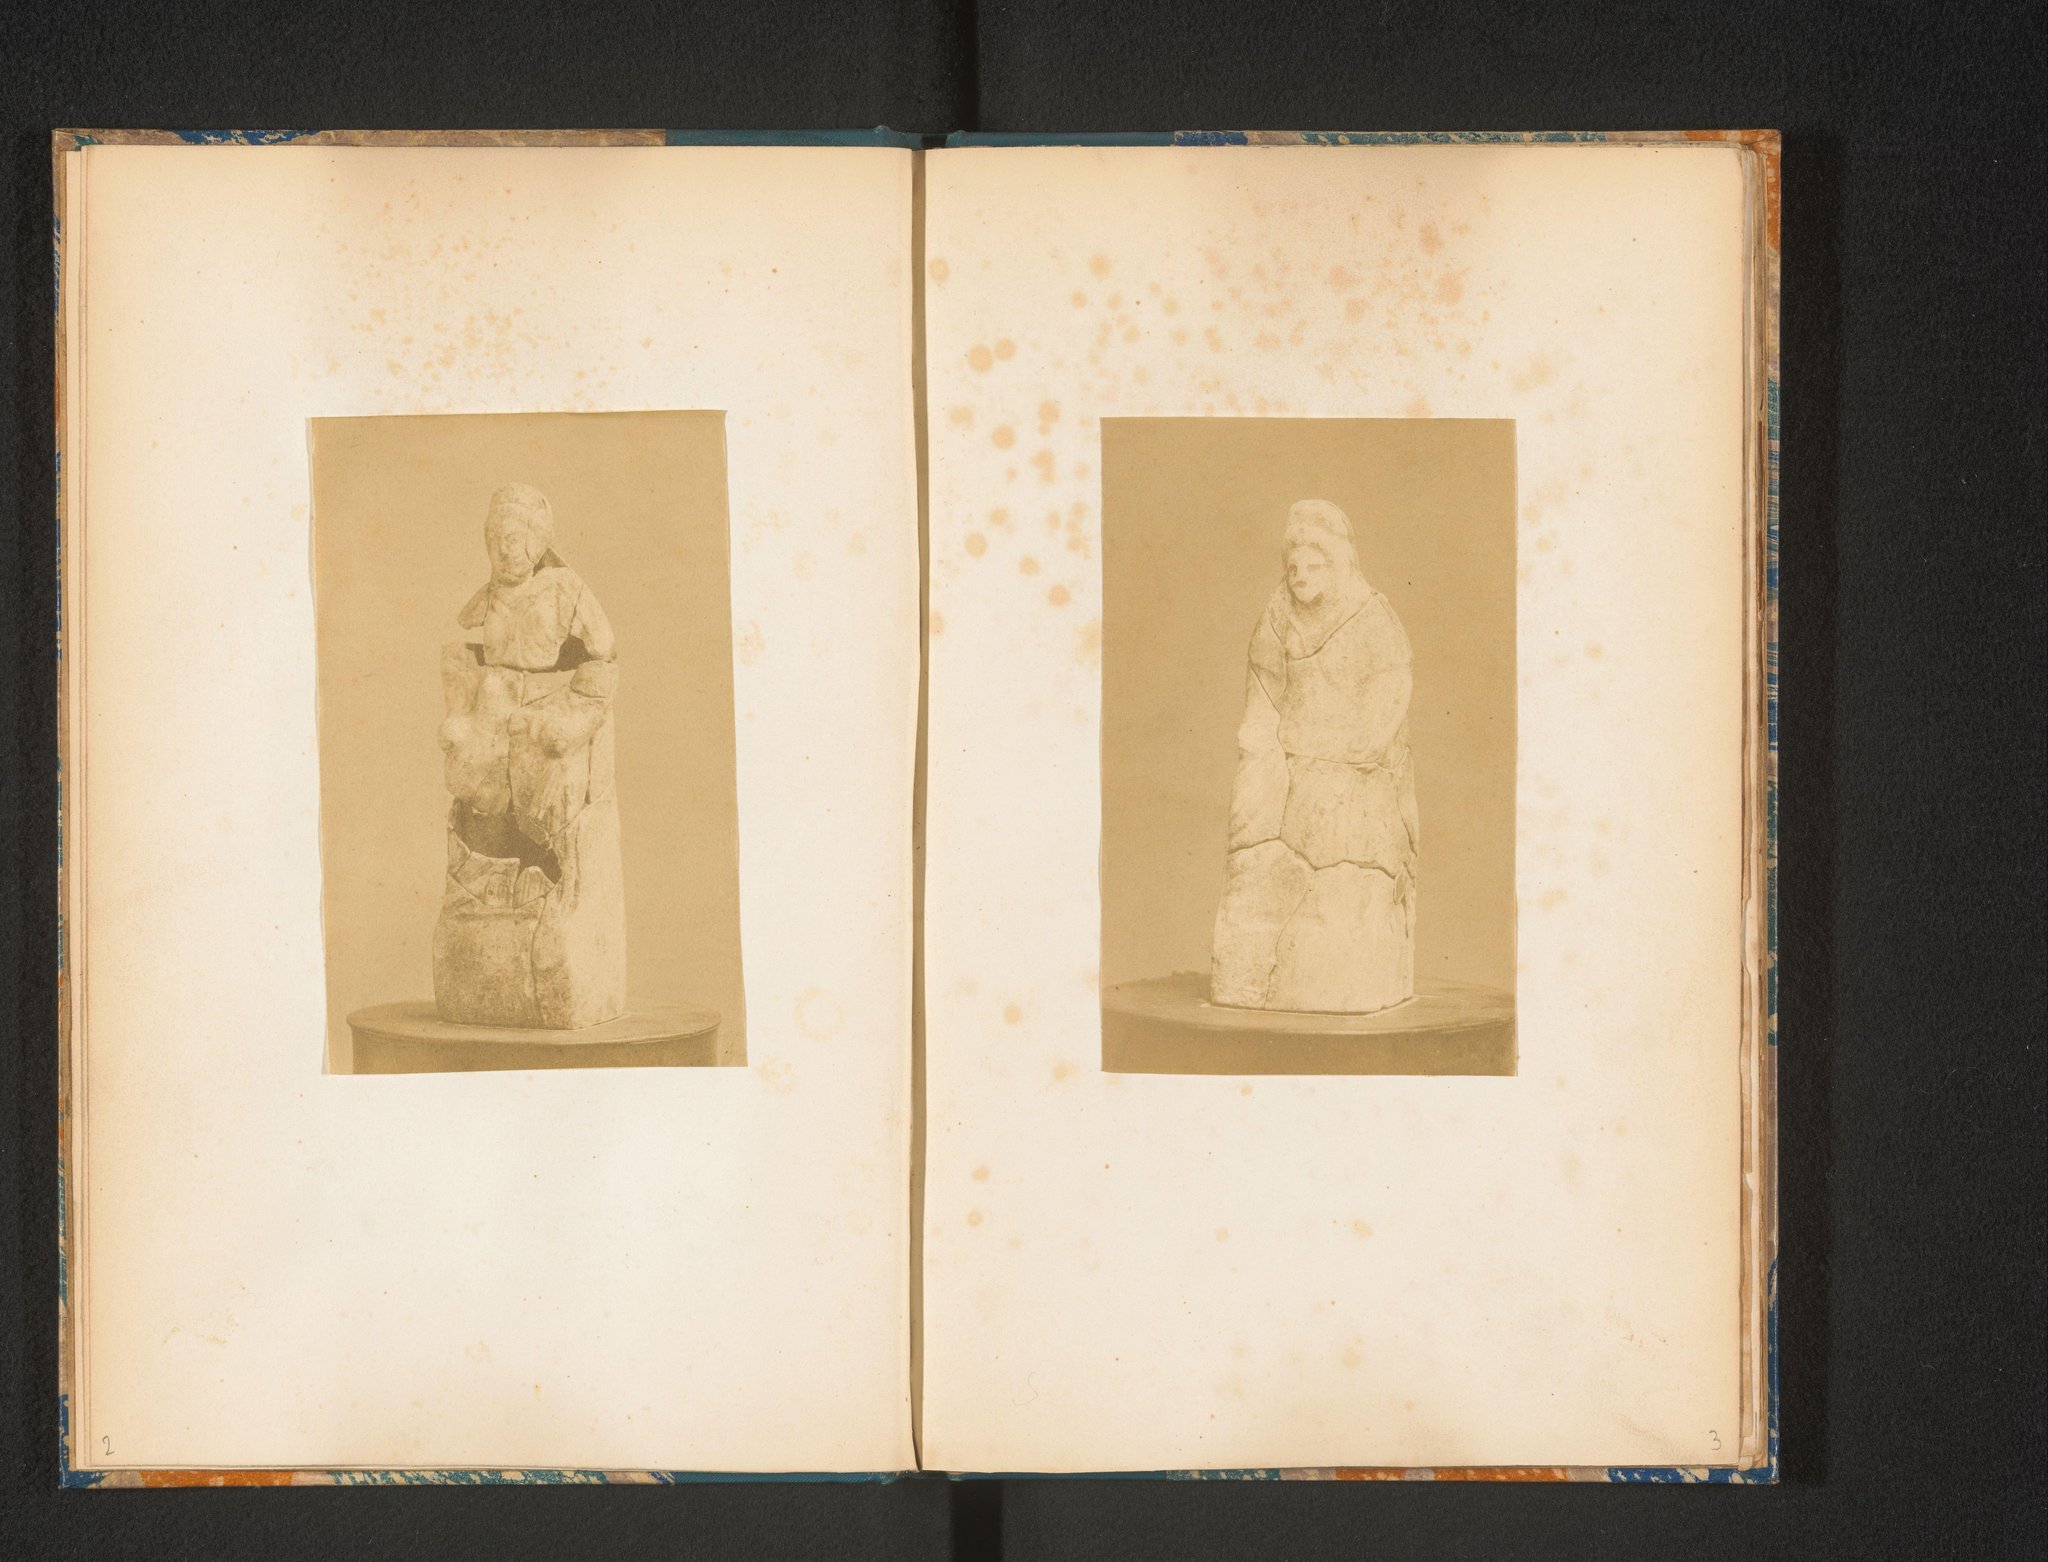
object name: photograph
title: Sculptuur, opgegraven in Juslenville in 1868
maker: Anonymous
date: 1868-1869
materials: photographic support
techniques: albumen print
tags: sculpture